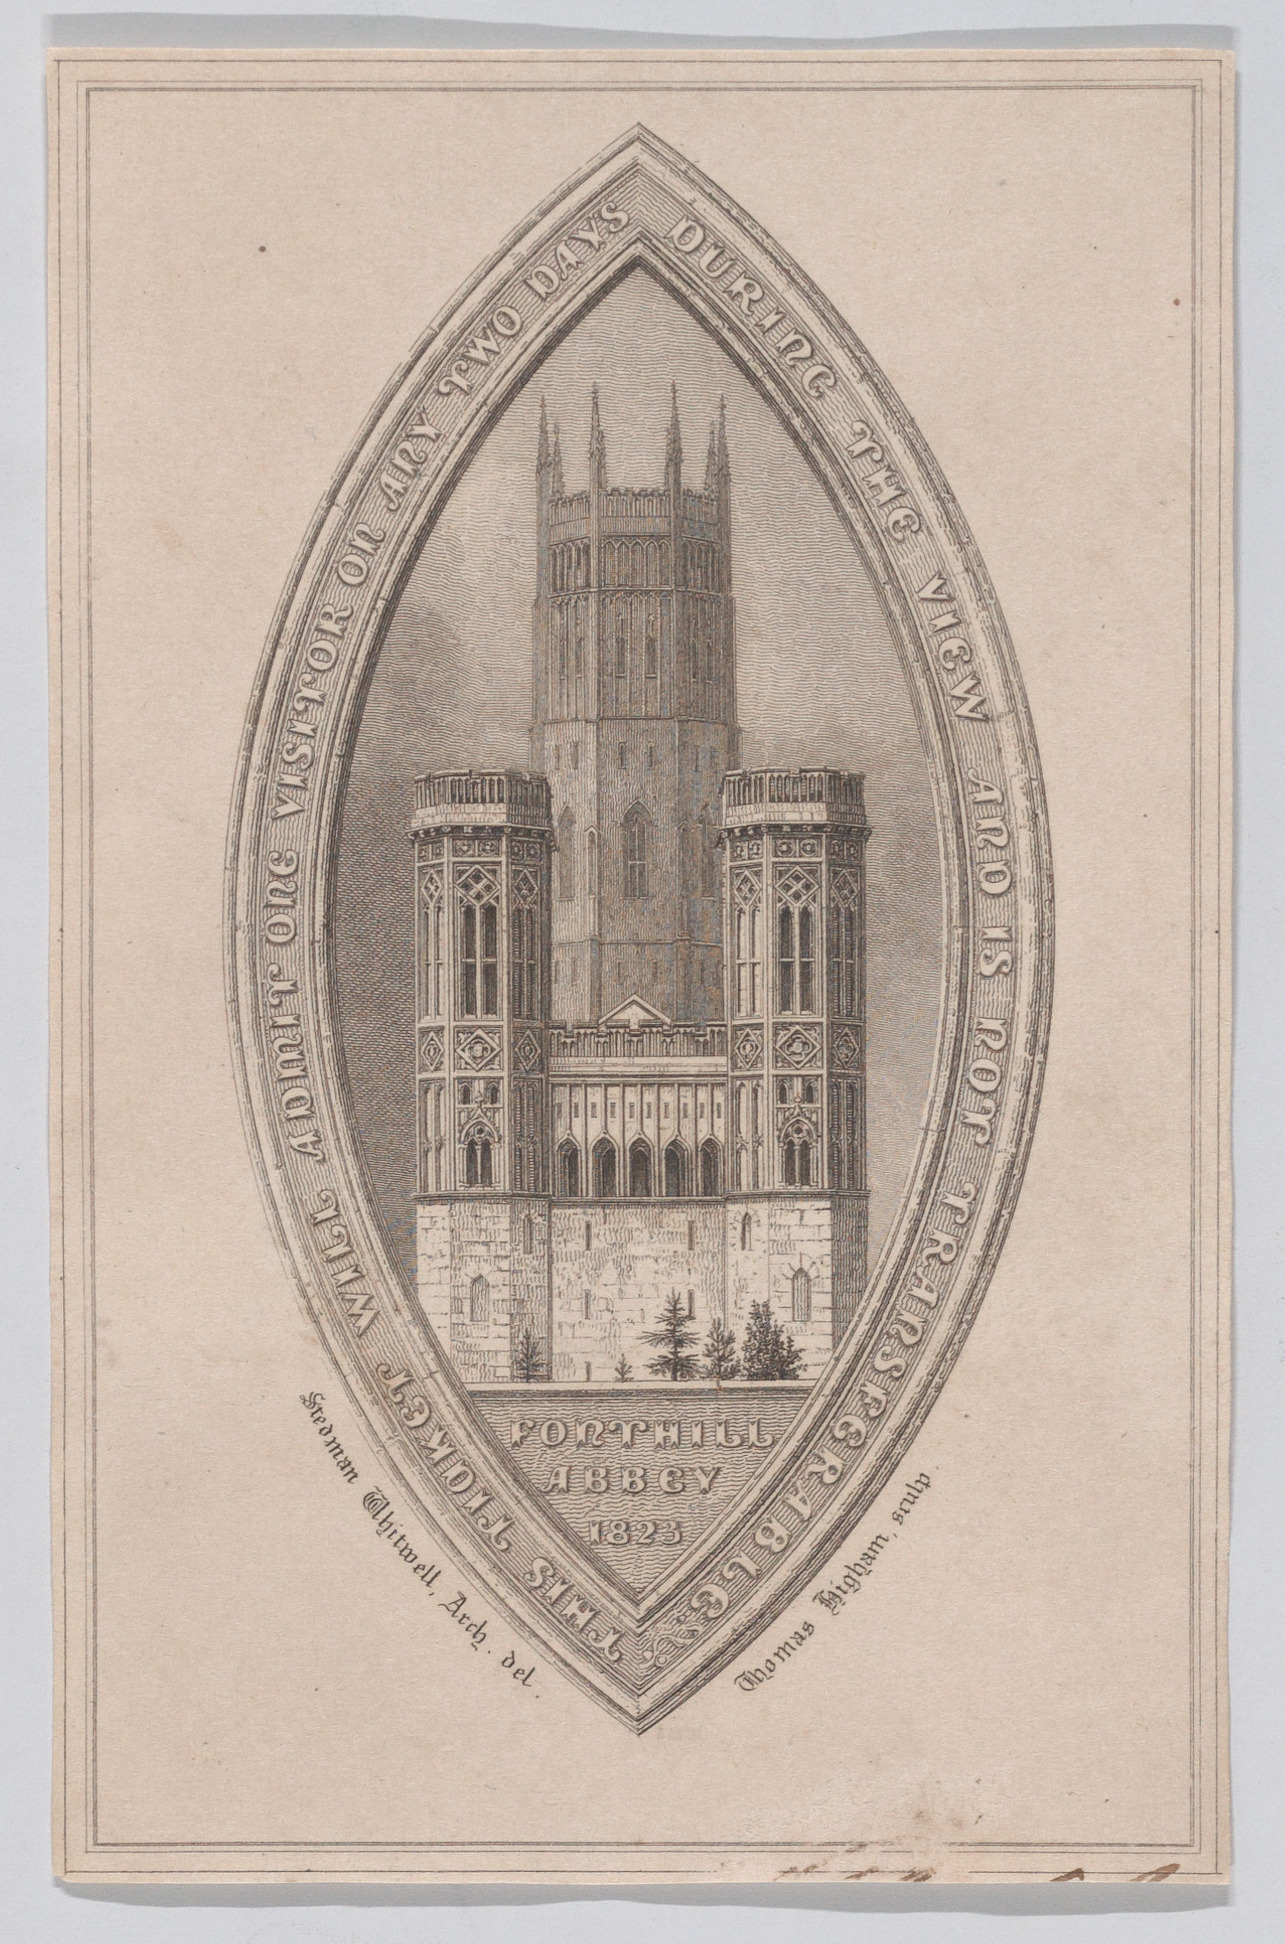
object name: print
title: Admission Ticket for Fonthill Abbey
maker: thomas stedman whitwell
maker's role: artist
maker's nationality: british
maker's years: 1784-1840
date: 1823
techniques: engraving